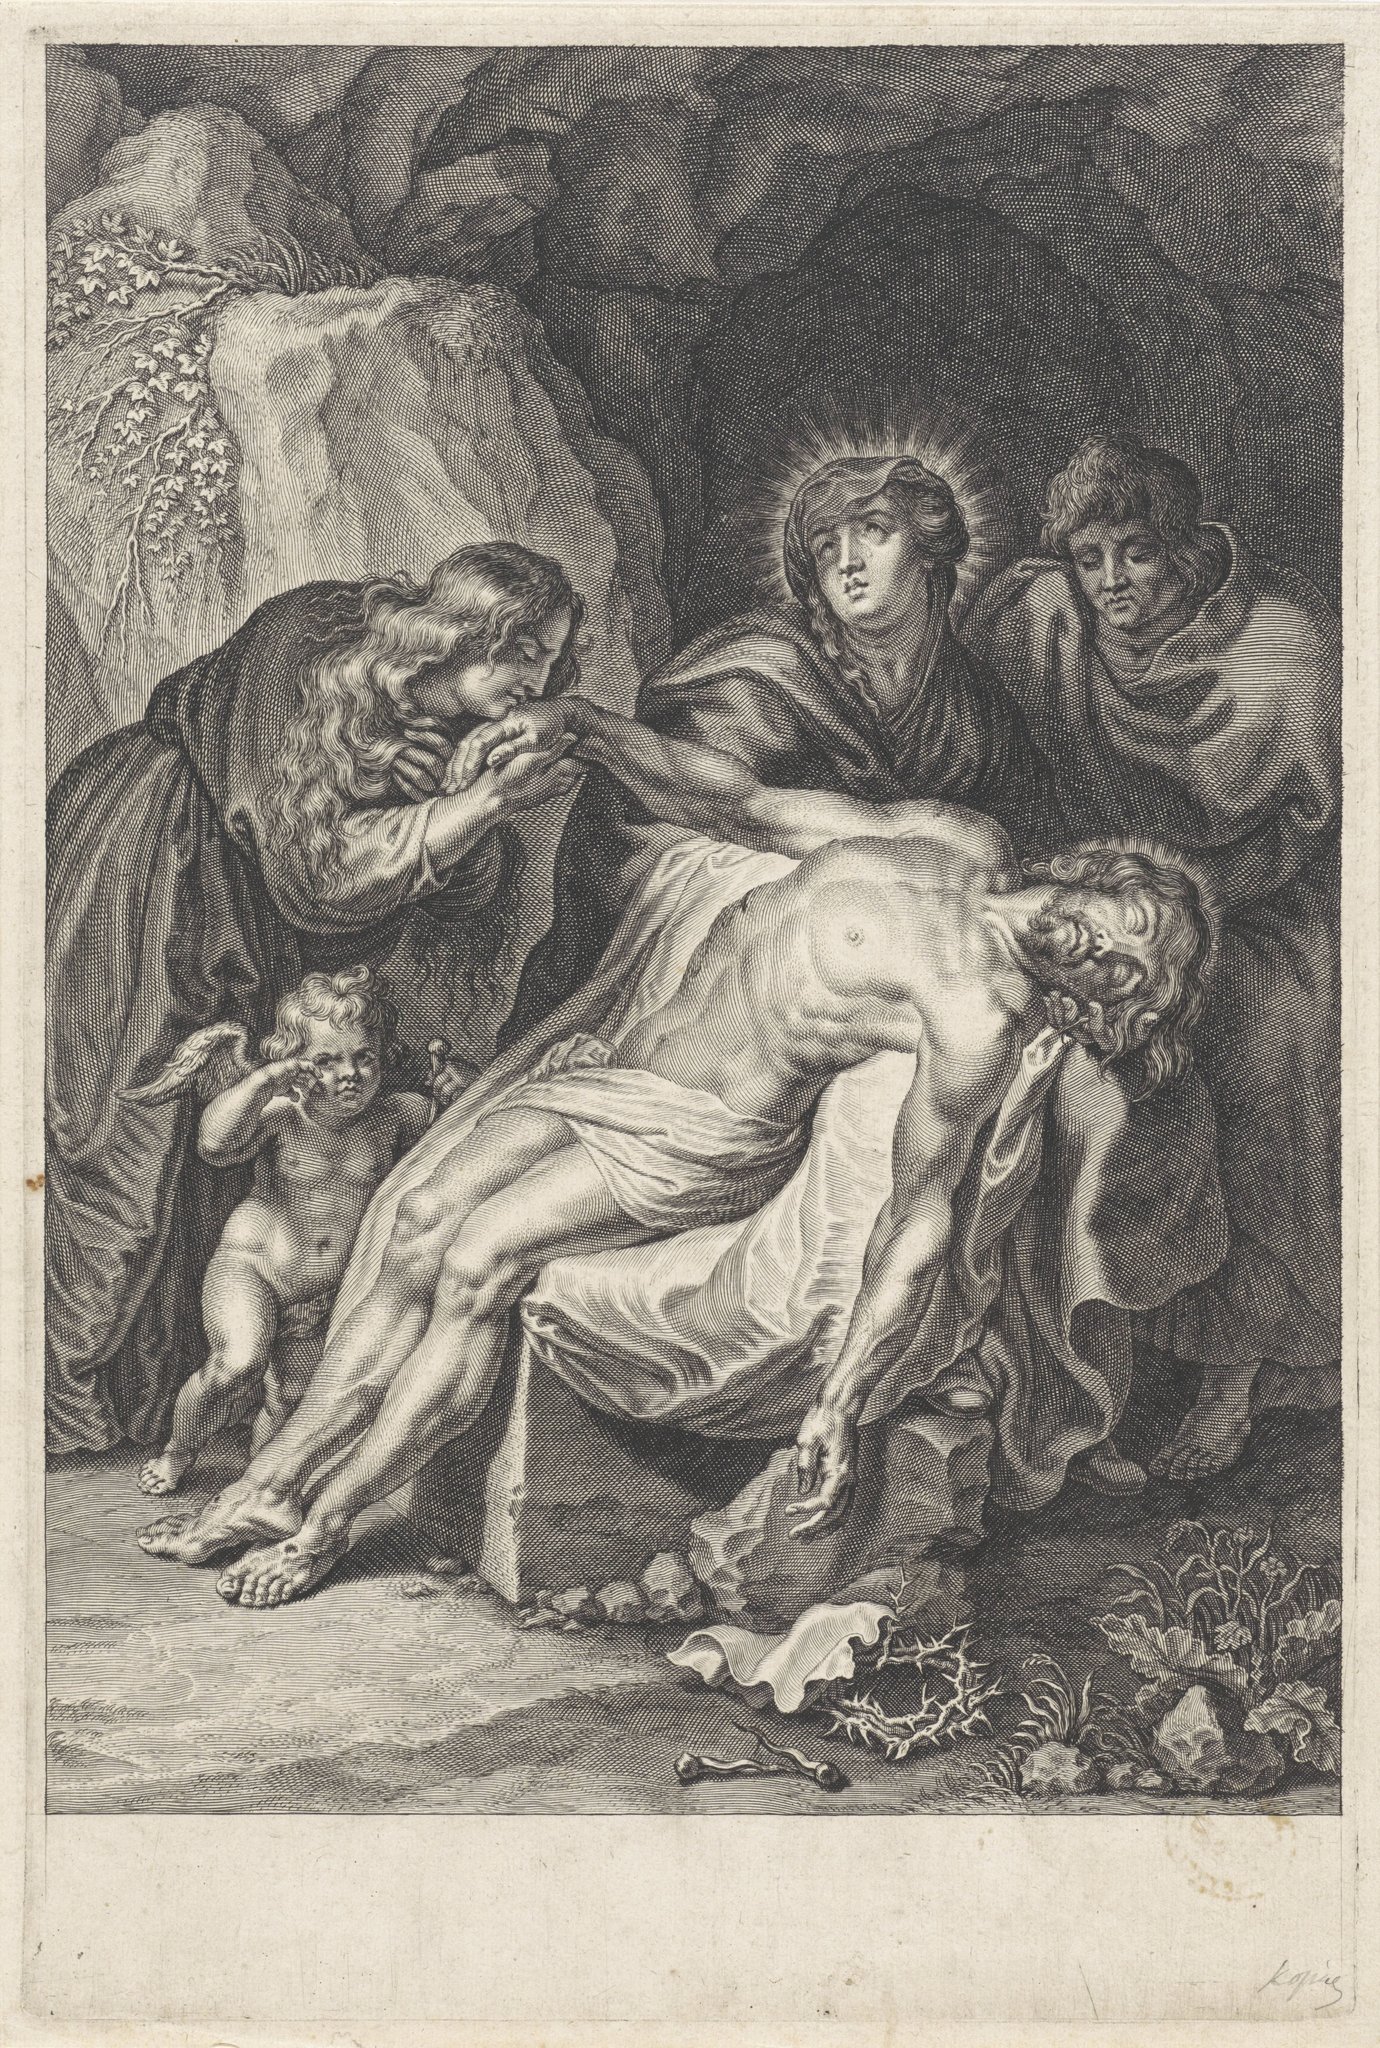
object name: print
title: Bewening van Christus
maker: Anonymous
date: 1615-1691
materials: paper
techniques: engraving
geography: low countries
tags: christ's body supported by mary, others present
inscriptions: collector's mark: Lugt 240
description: Maria zit op de graftombe voor de geopende grot. Ze ondersteunt het hoofd van Christus. Maria Magdalena kust zijn hand en Johannes de Evangelist kijkt bedroefd toe. Links huilt een engel. Rechtsvoor liggen enkele passiewerktuigen.